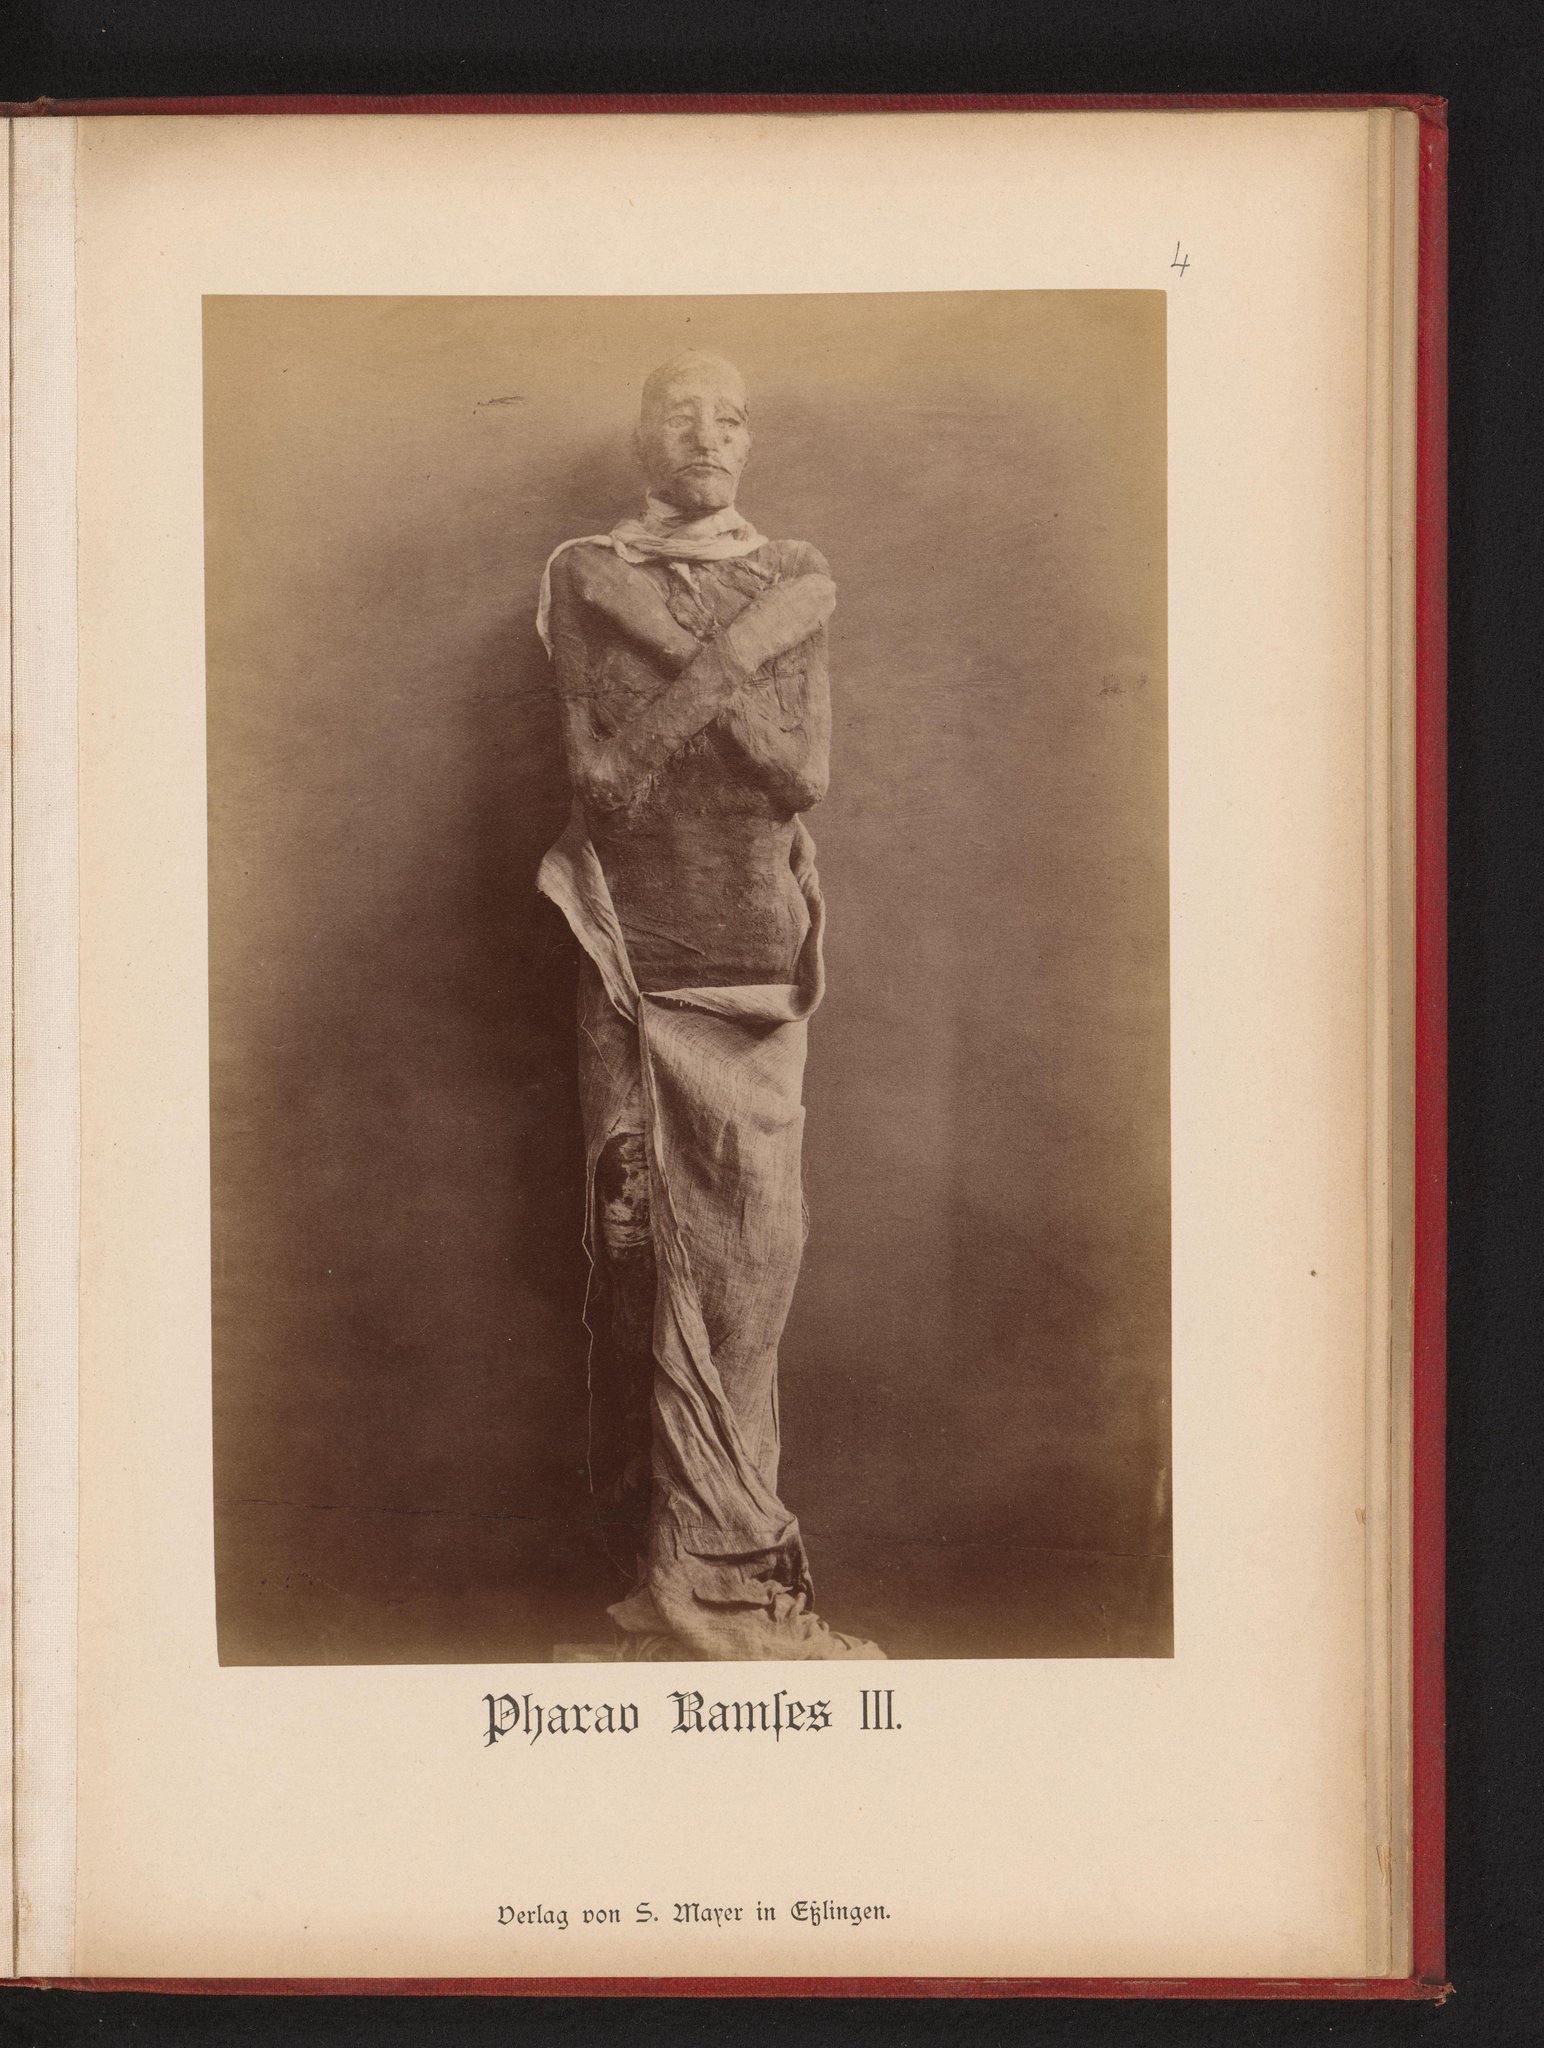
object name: page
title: Pharao Ramses III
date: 1886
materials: photographic support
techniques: albumen print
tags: thebes, king, mummy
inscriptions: inscription: ‘Verlag von S. Mayer in Esslingen’